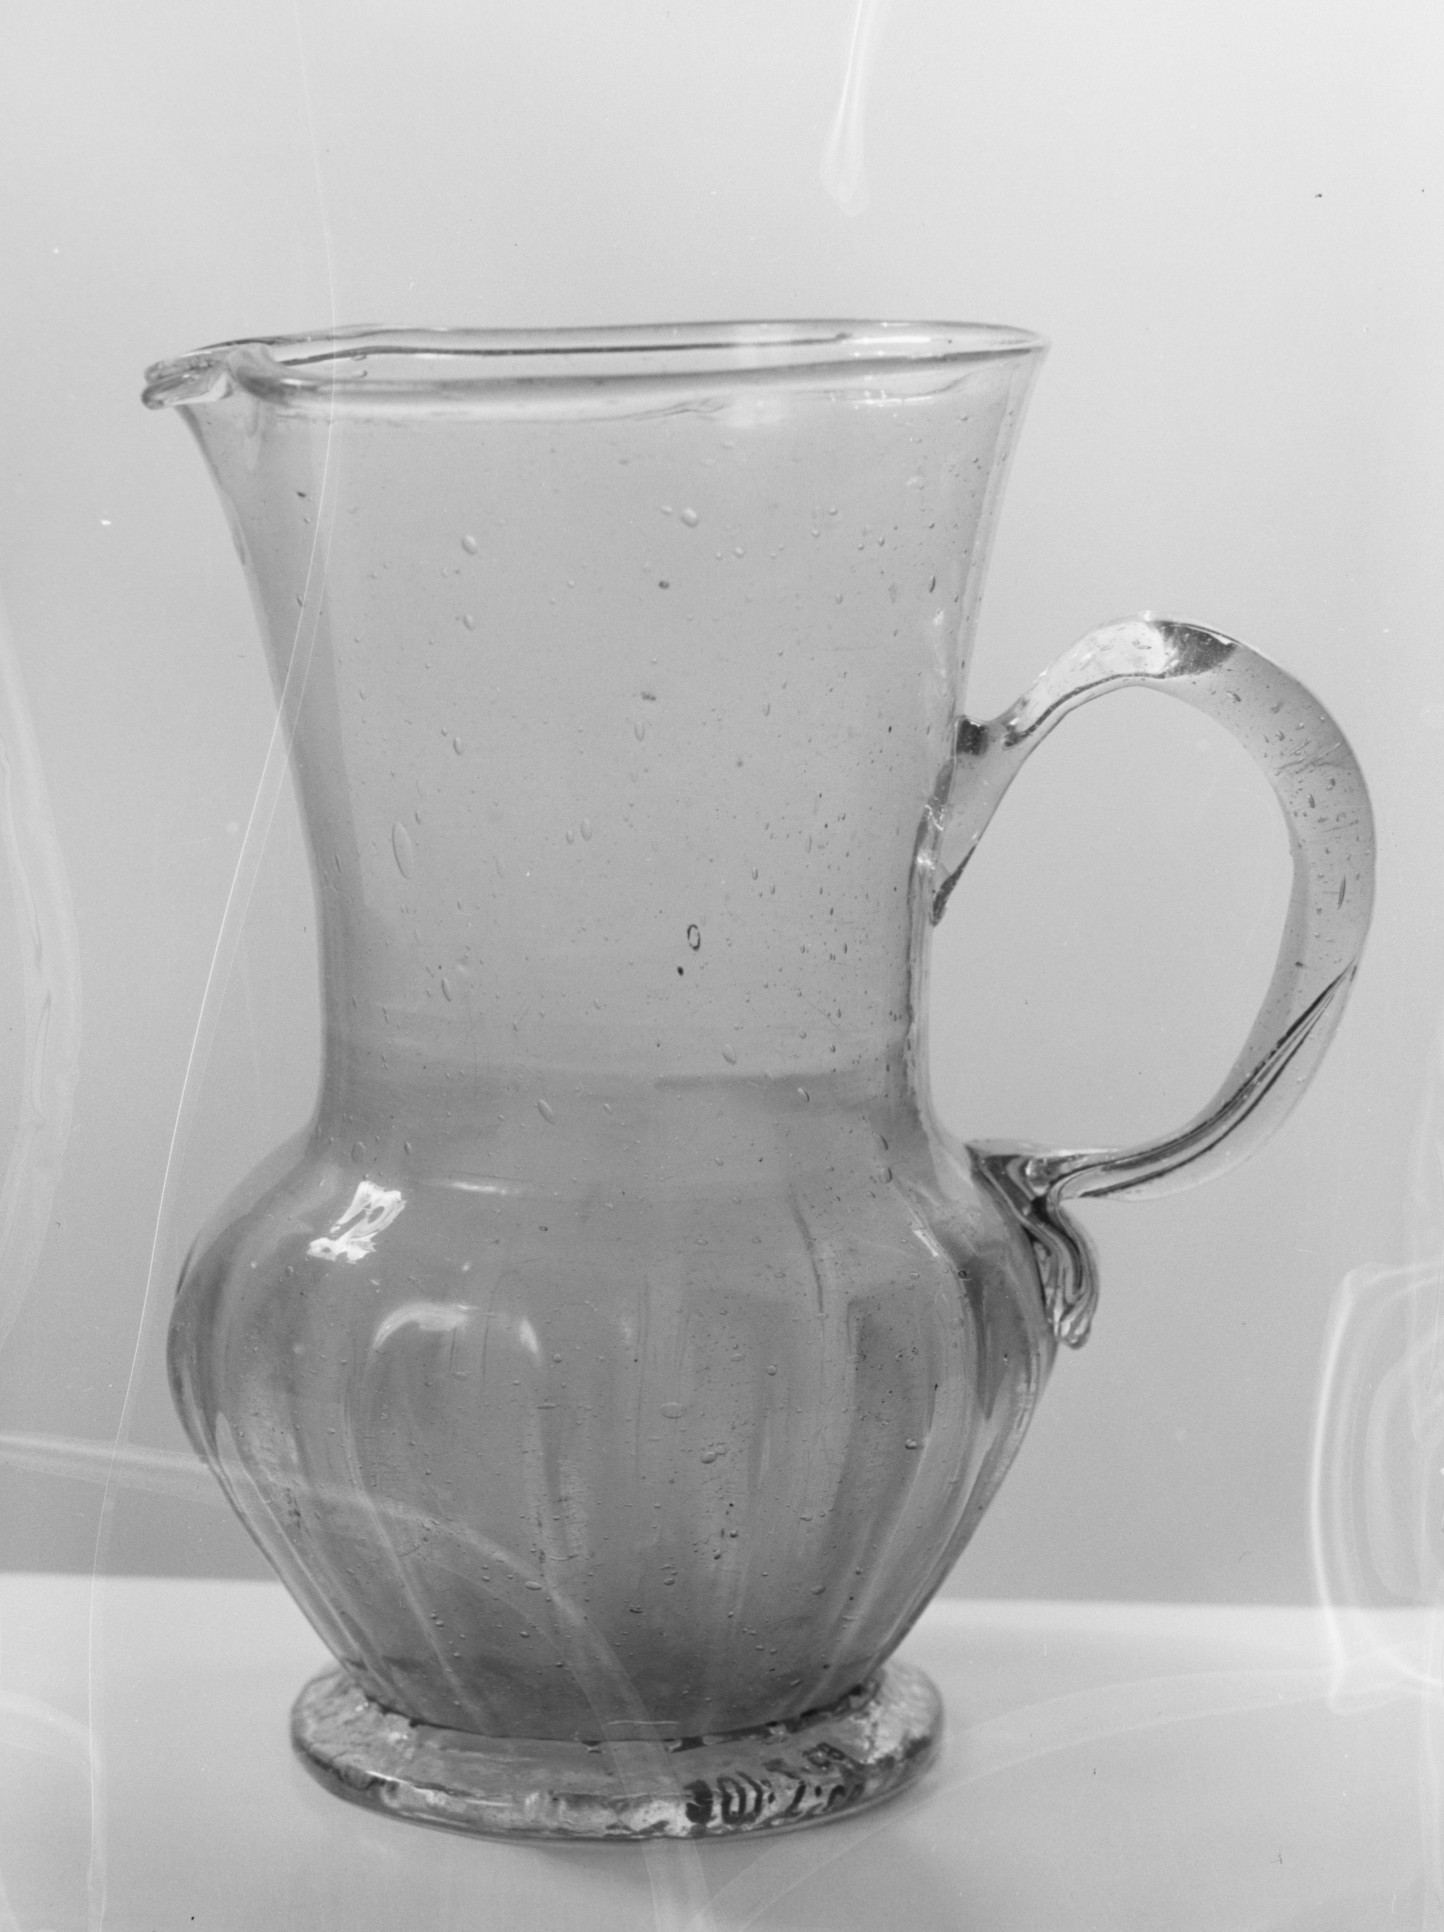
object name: jug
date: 1701-1800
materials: glass